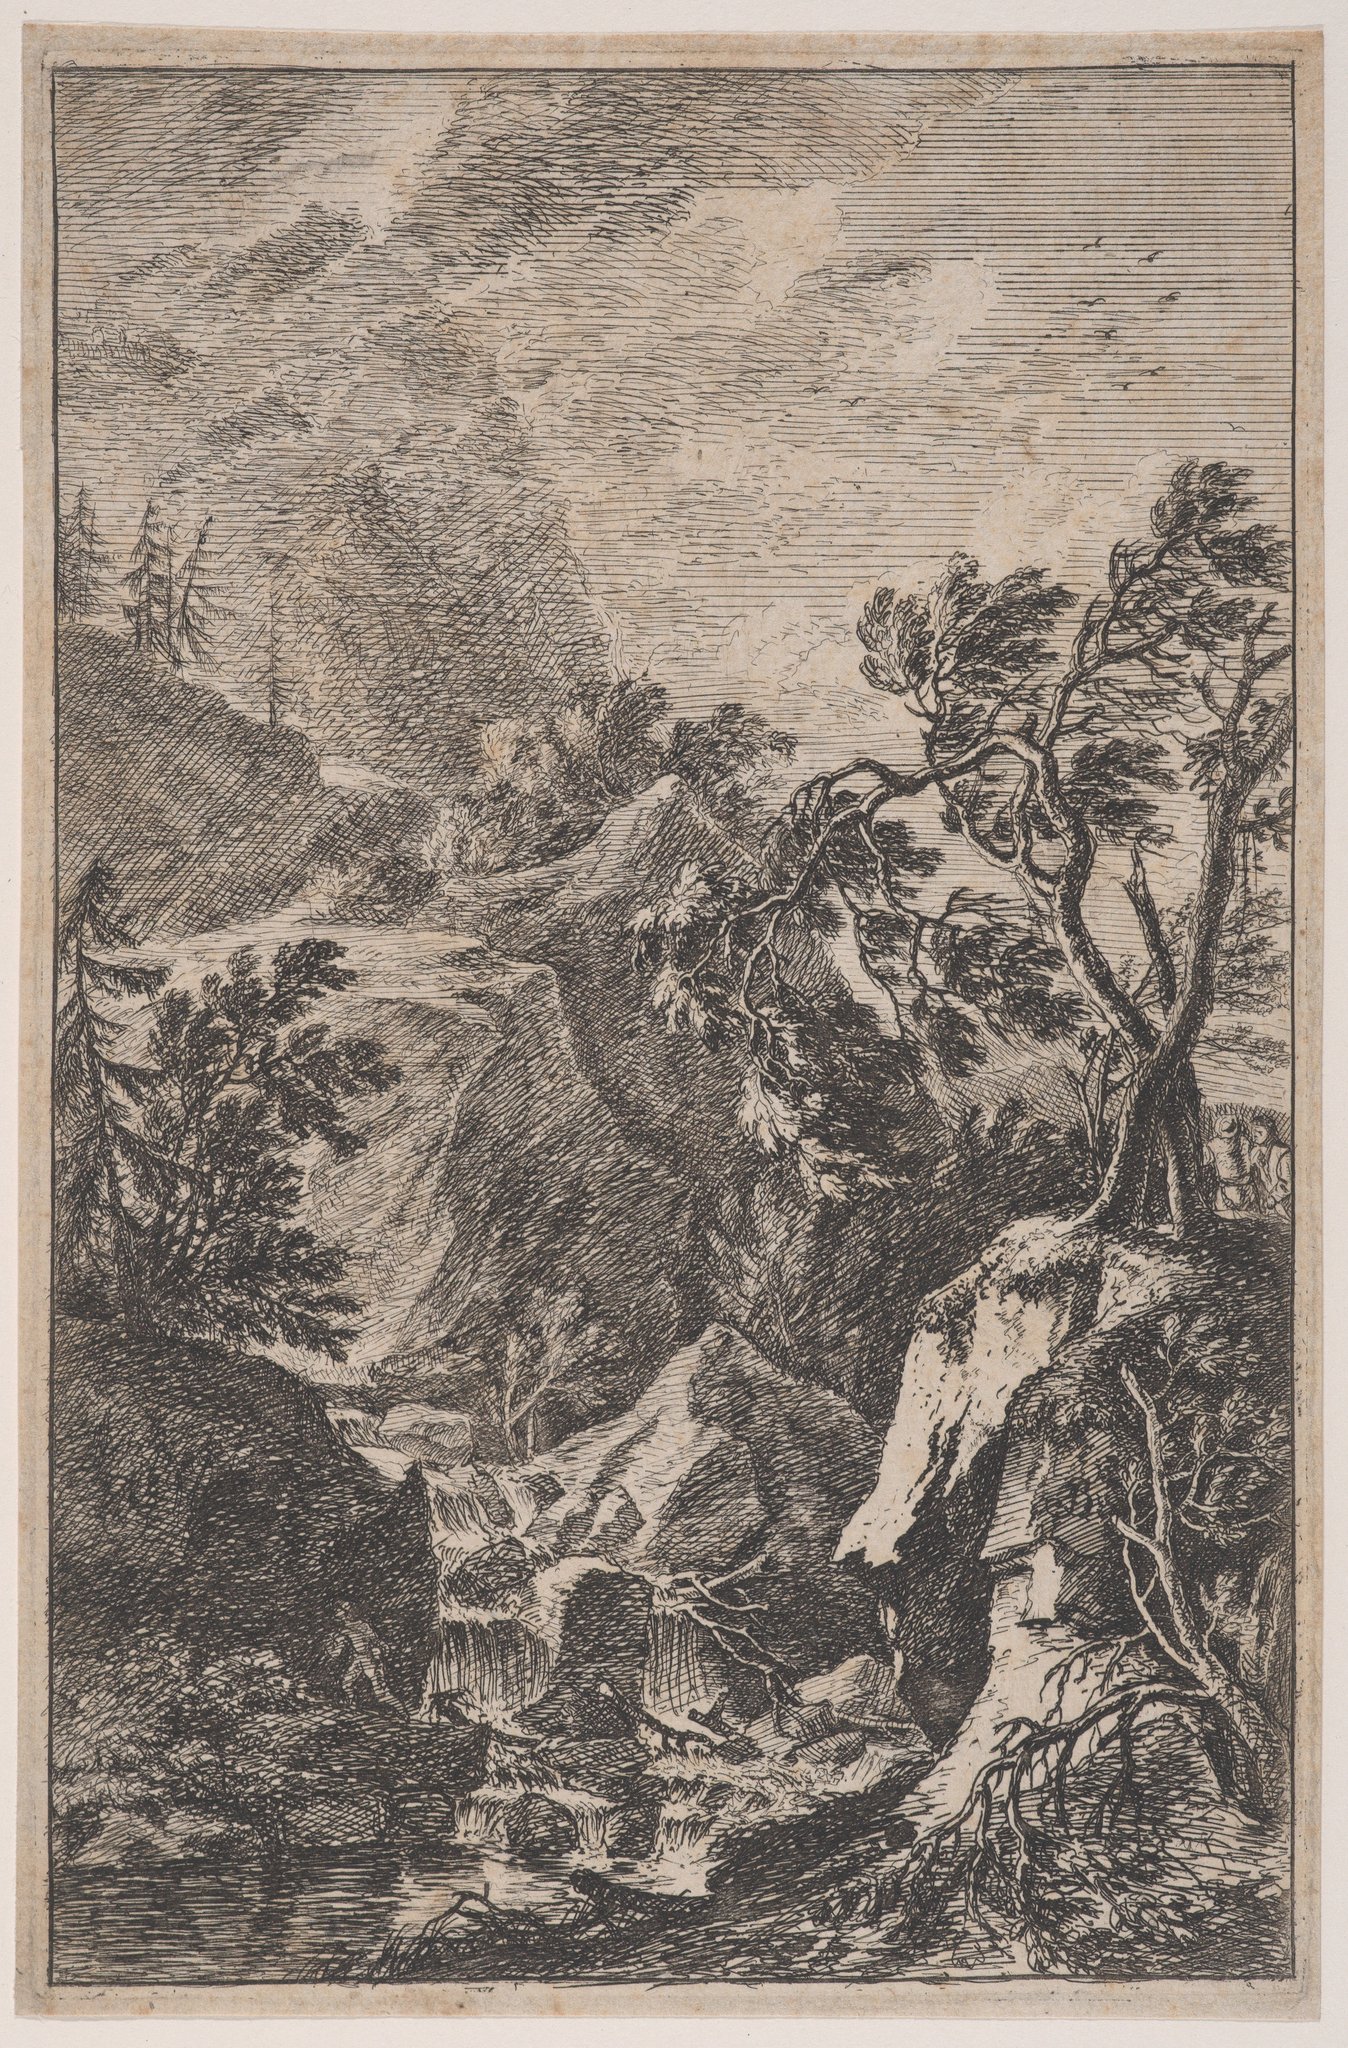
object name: print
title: Plate 6: two male figures standing on a rock at right, a waterfall at center with another male figure on its left bank, from 'Landscapes in the manner of Salvator Rosa' (Die Landschaften in Sal. Rosa's)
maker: franz joachim beich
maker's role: artist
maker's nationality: german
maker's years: 1665-1745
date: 1700-1725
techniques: etching